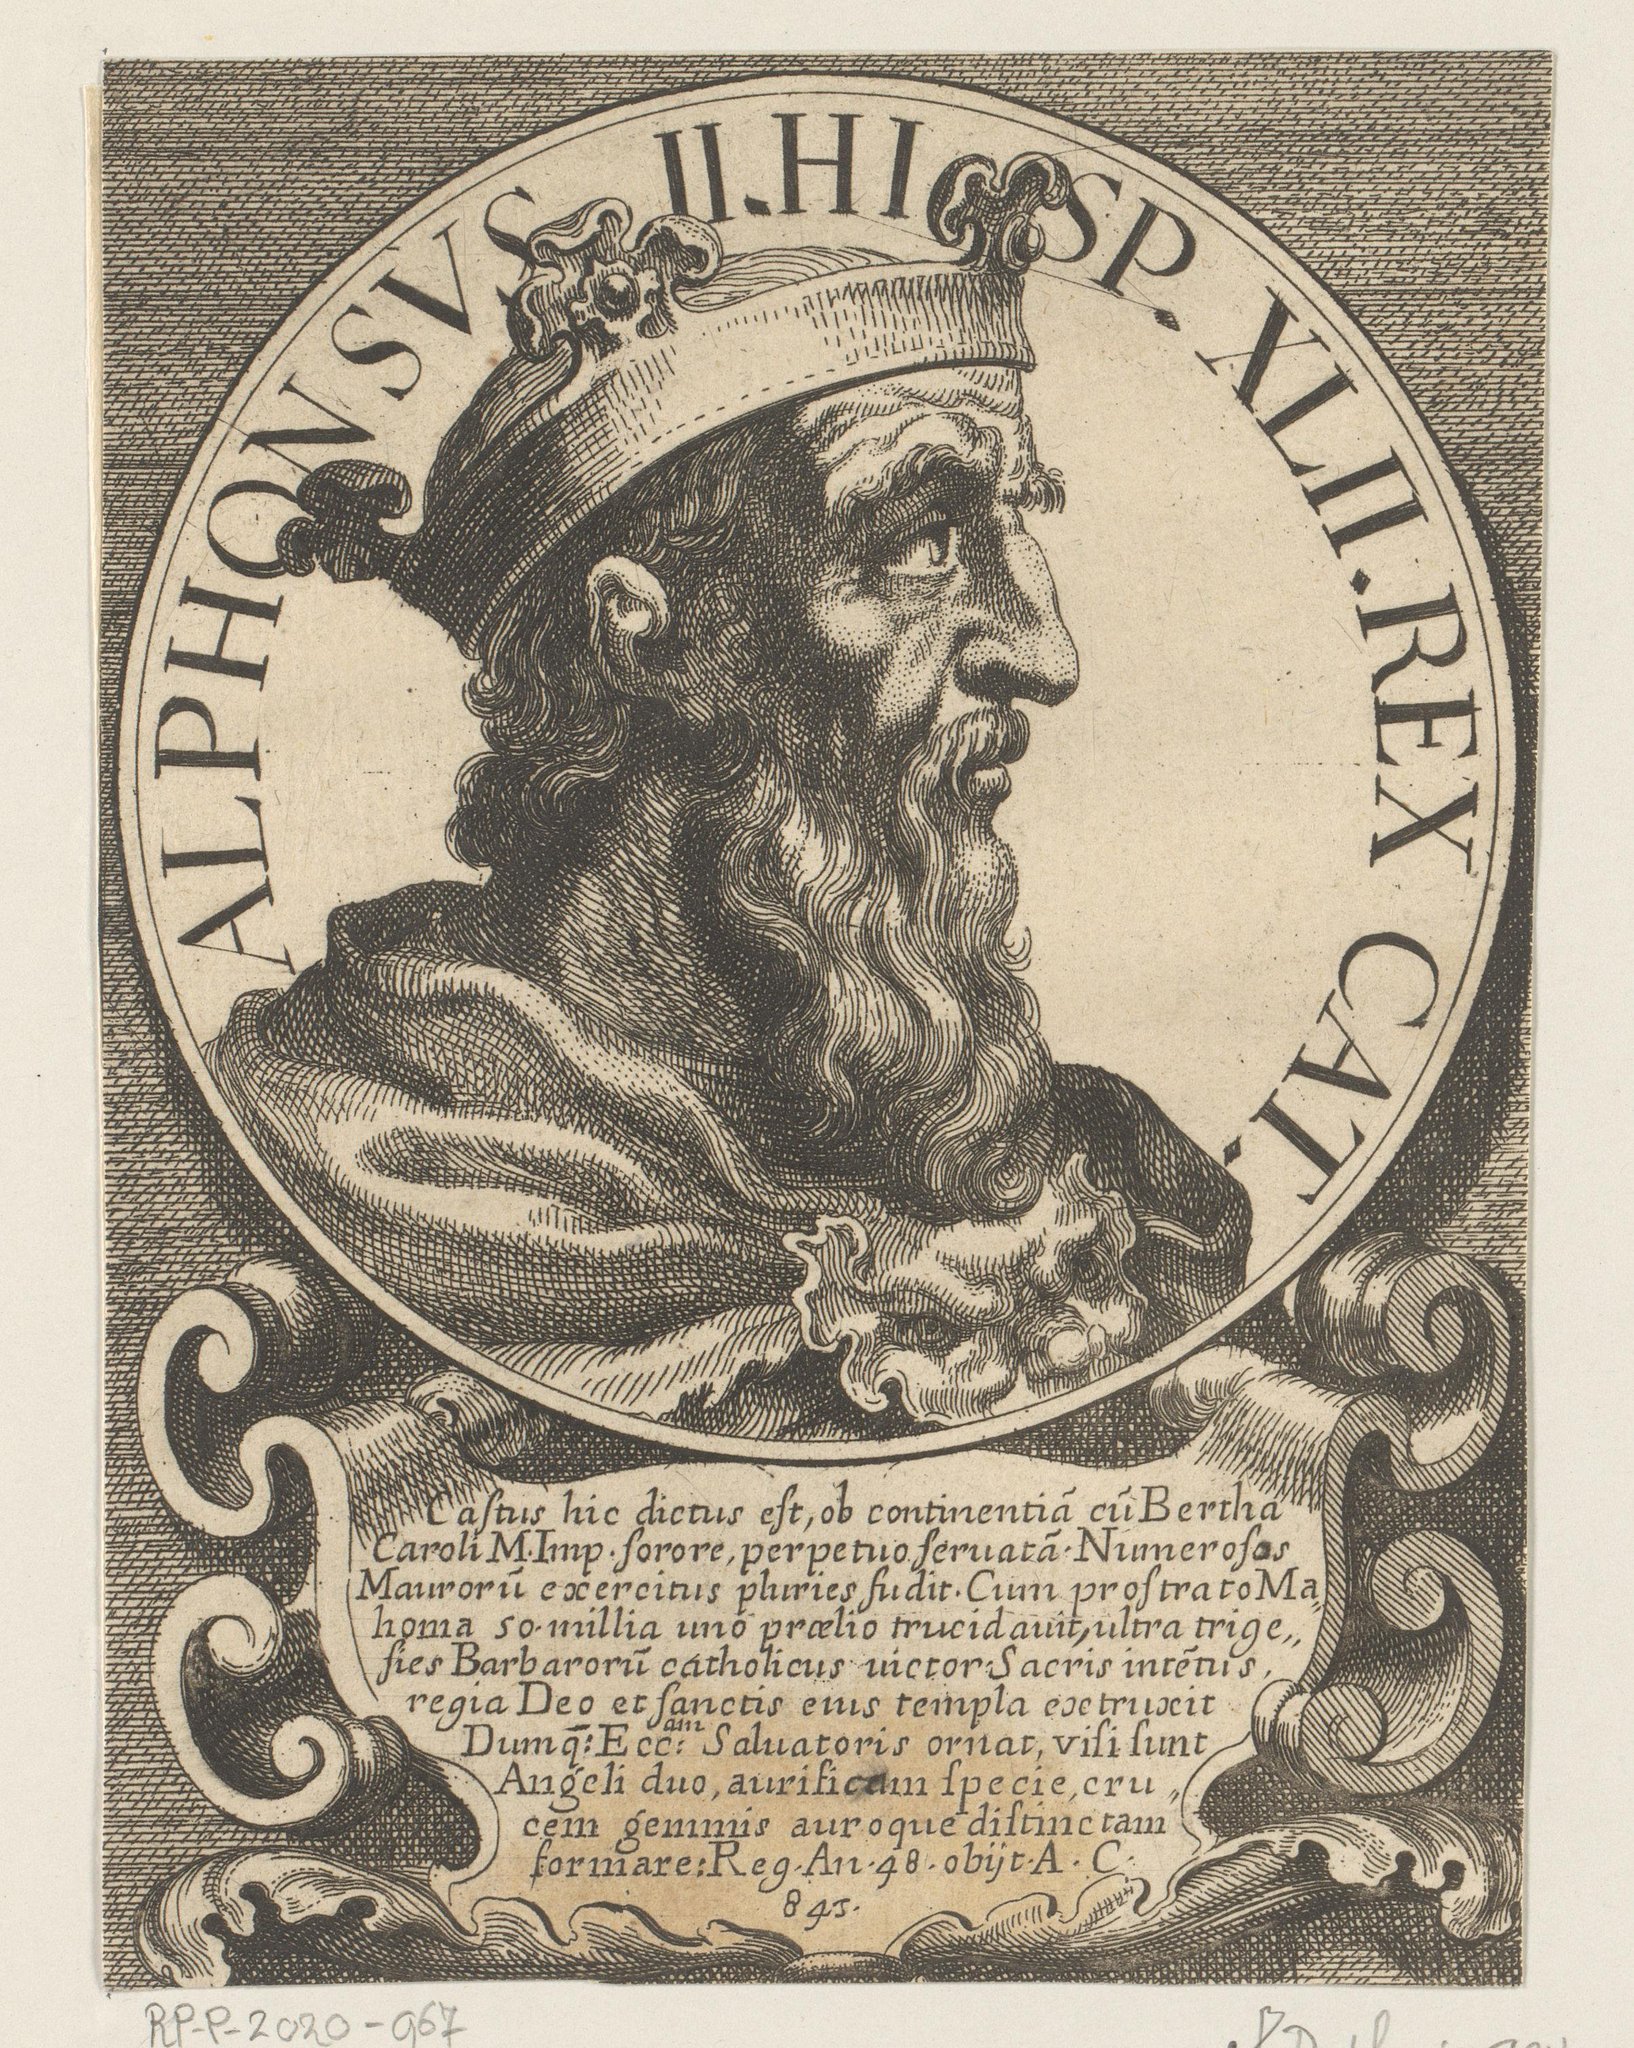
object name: print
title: Portret van Alfons II, koning van Asturië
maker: arnold van westerhout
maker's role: print maker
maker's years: 1651-1725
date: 1684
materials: paper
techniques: engraving, etching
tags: historical persons, ruler, sovereign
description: Portret ook gebruikt in: Niphus, Agustinus. Effigies et series regum Hispaniae primum ex Gothis Christianorum (...). Rome: s.n., 1684.